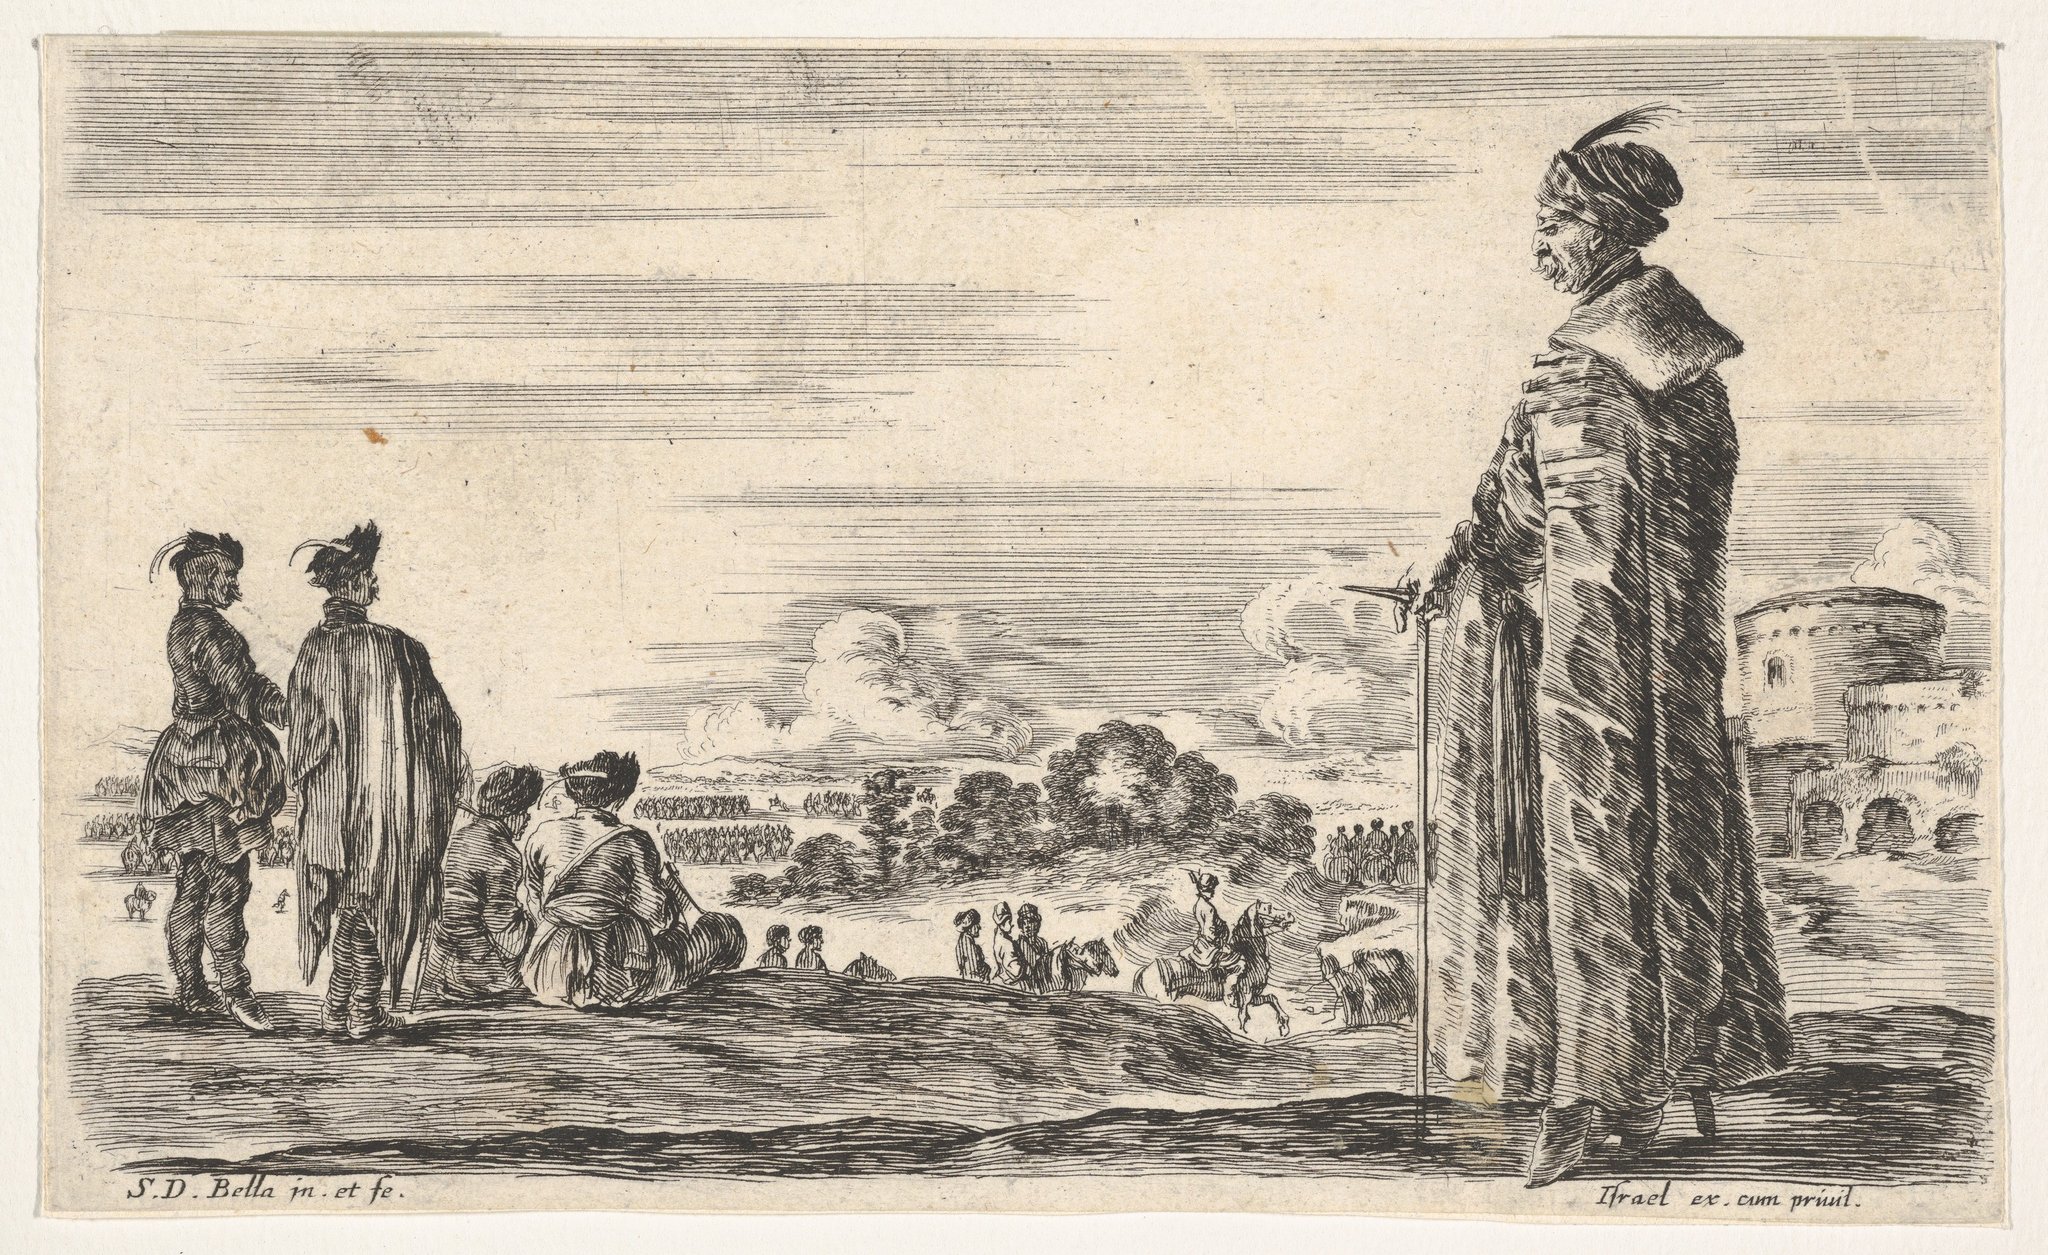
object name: print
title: A Polish man in a long robe standing at right in profile, facing left, other Polish men to left, groups of horsemen to left in background and a castle to right in background, from "Various figures and lands" (Diverse figure e paesi)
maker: stefano della bella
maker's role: artist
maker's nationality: italian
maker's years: 1610-1664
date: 1649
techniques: etching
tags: men,horses